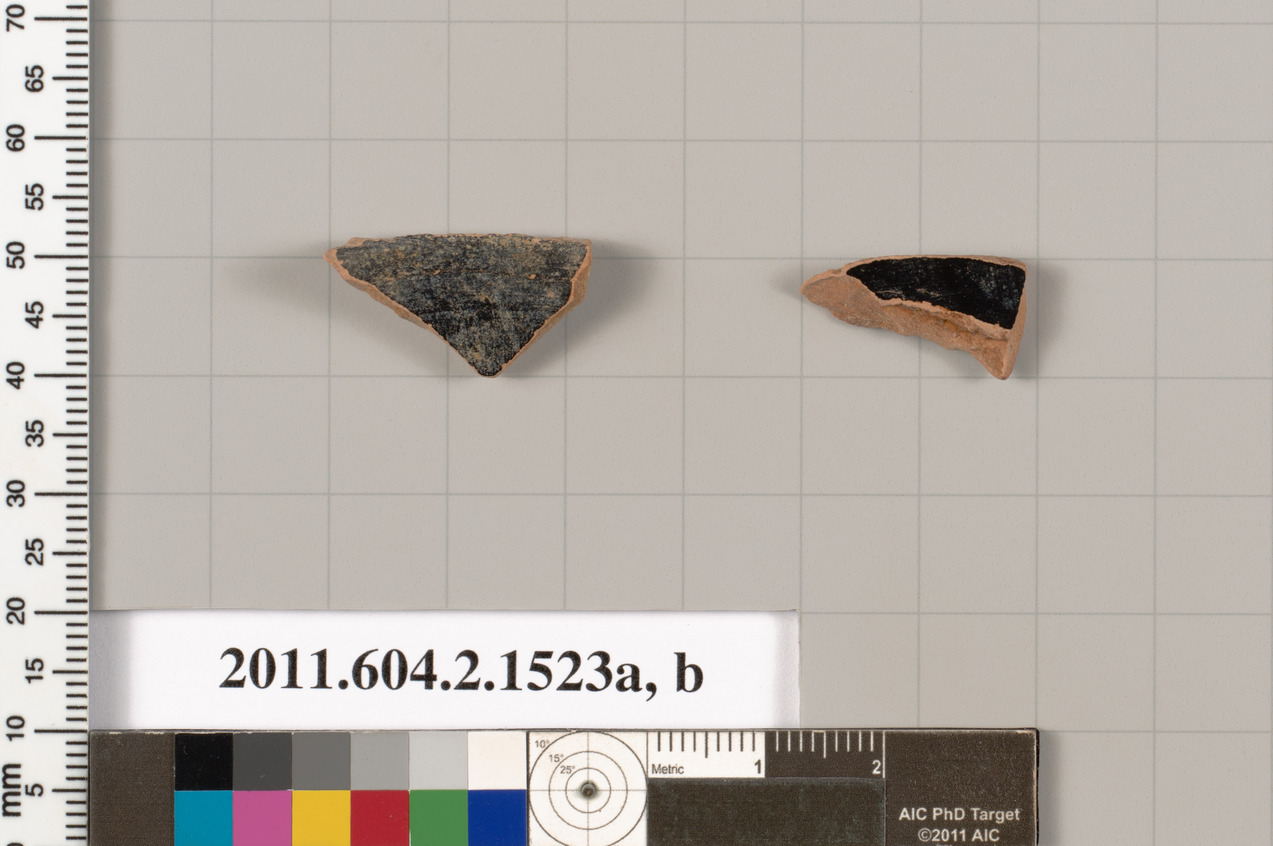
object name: skyphos fragment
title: Terracotta fragments of skyphoi (deep drinking cups)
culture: greek, attic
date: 600-401 BCE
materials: terracotta